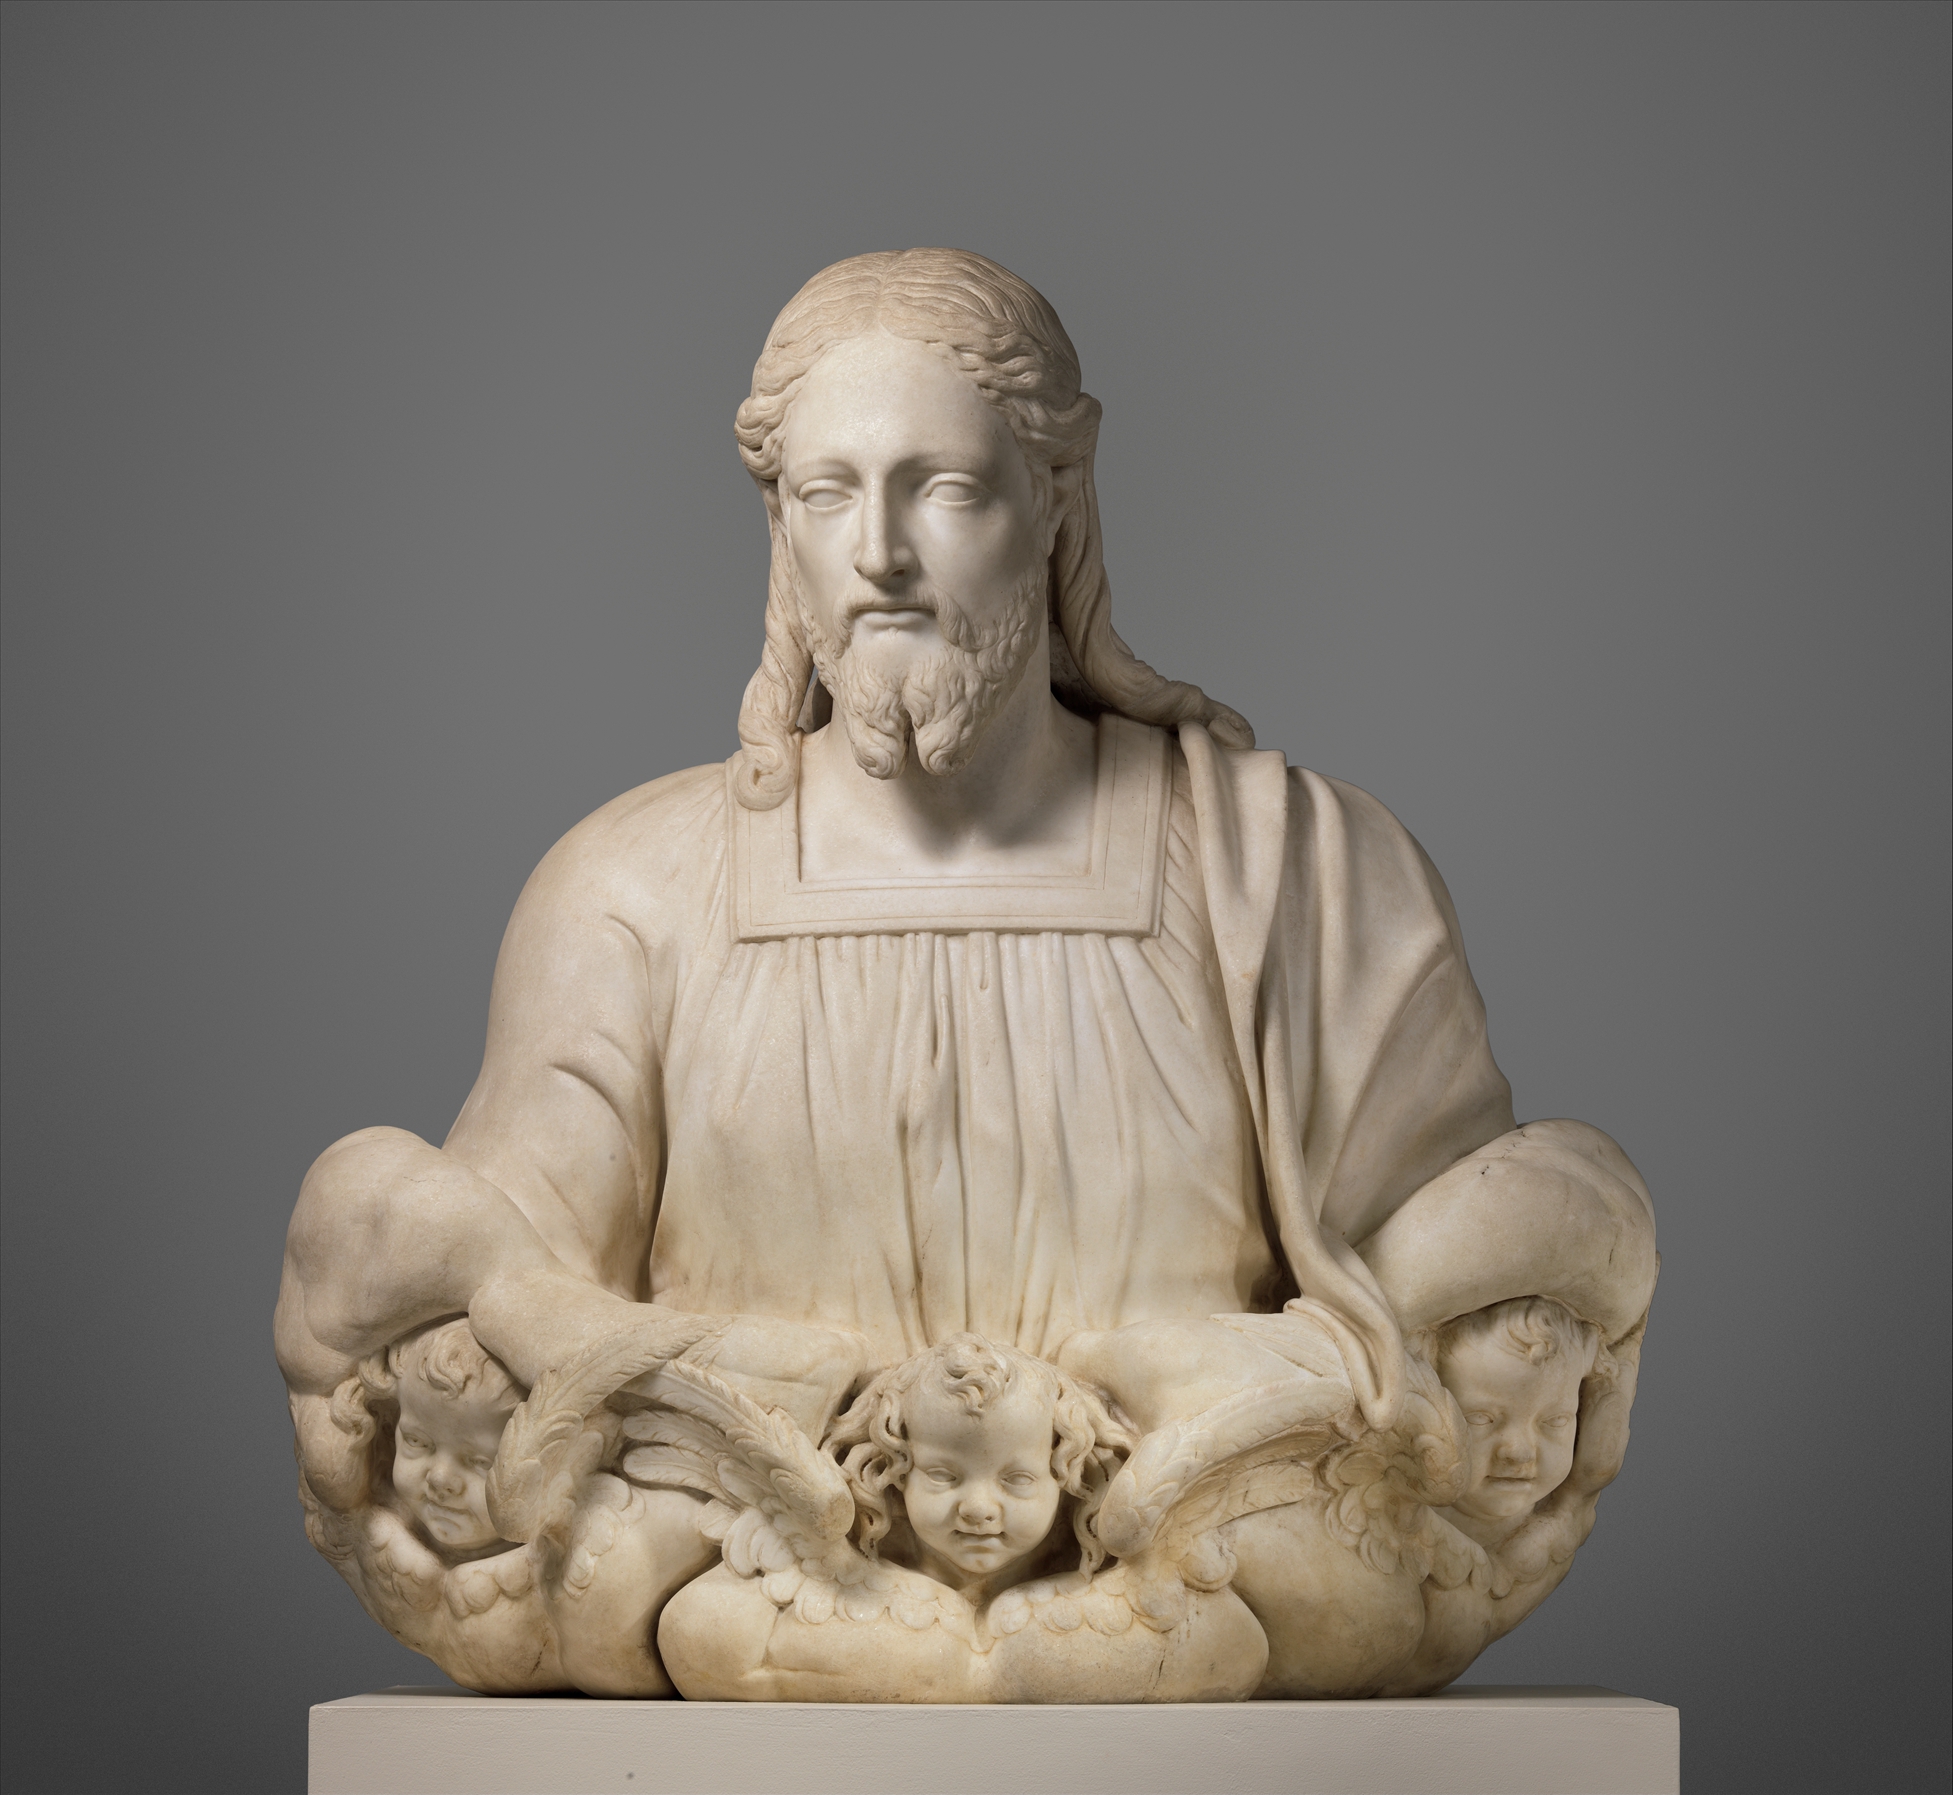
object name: bust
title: Christ the Redeemer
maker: antonio novelli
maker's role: artist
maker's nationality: italian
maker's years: 1600-1662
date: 1650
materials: marble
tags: infants,christ